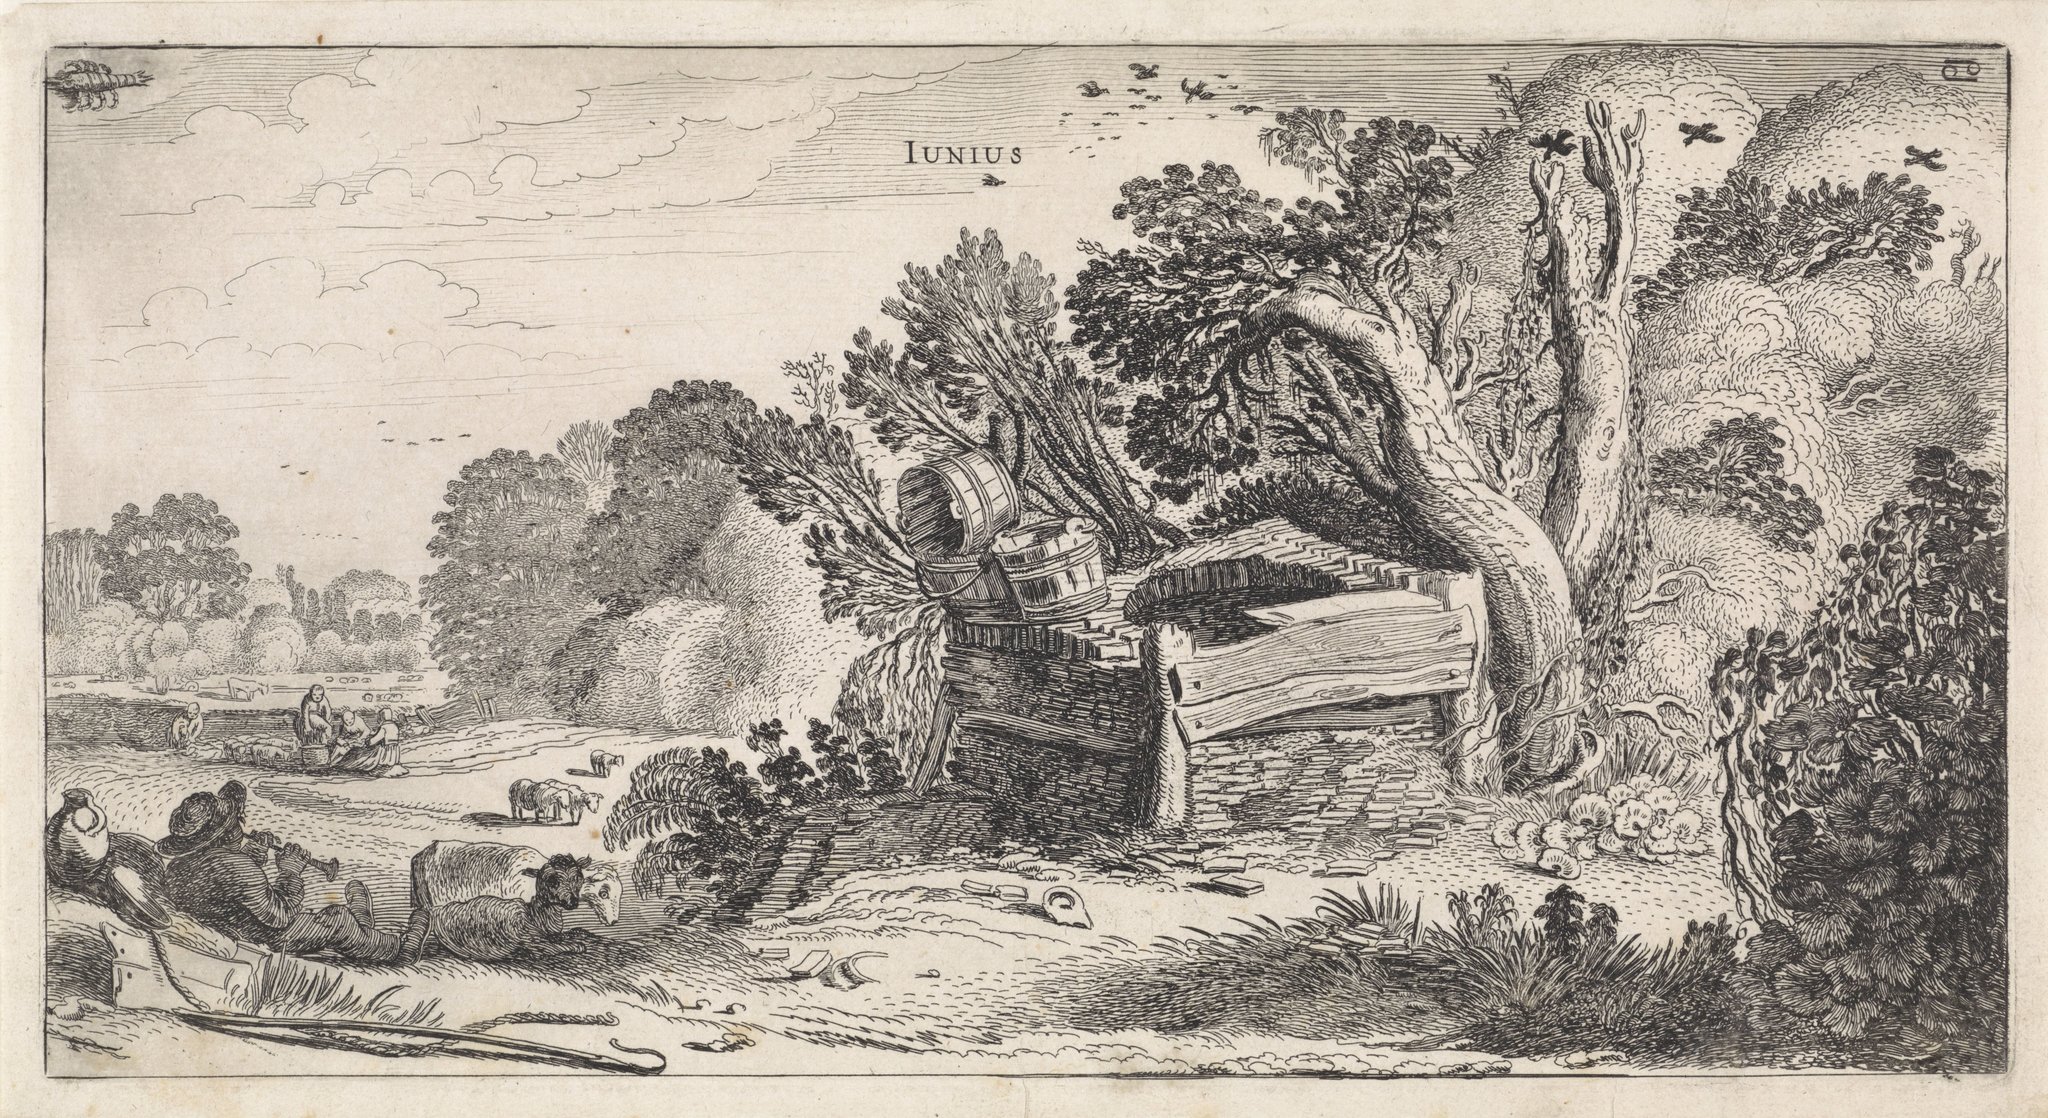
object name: print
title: De twaalf maanden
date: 1616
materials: paper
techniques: etching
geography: northern netherlands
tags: cancer (zodiacal sign of june), landscape symbolizing june, well, herding, herdsman, herdswoman, shepherd, shepherdess, cowherd, etc., flute, aulos, tibia - cc - out of doors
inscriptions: collector's mark: Lugt 964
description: Een landschap met een een waterput, voorstellende de maand juni. Links een op een fluit spelende herder bij zijn kudde. Links- en rechtsboven de bij deze maand behorende symbolen van het sterrenbeeld kreeft. Zesde prent uit een serie van twaalf.